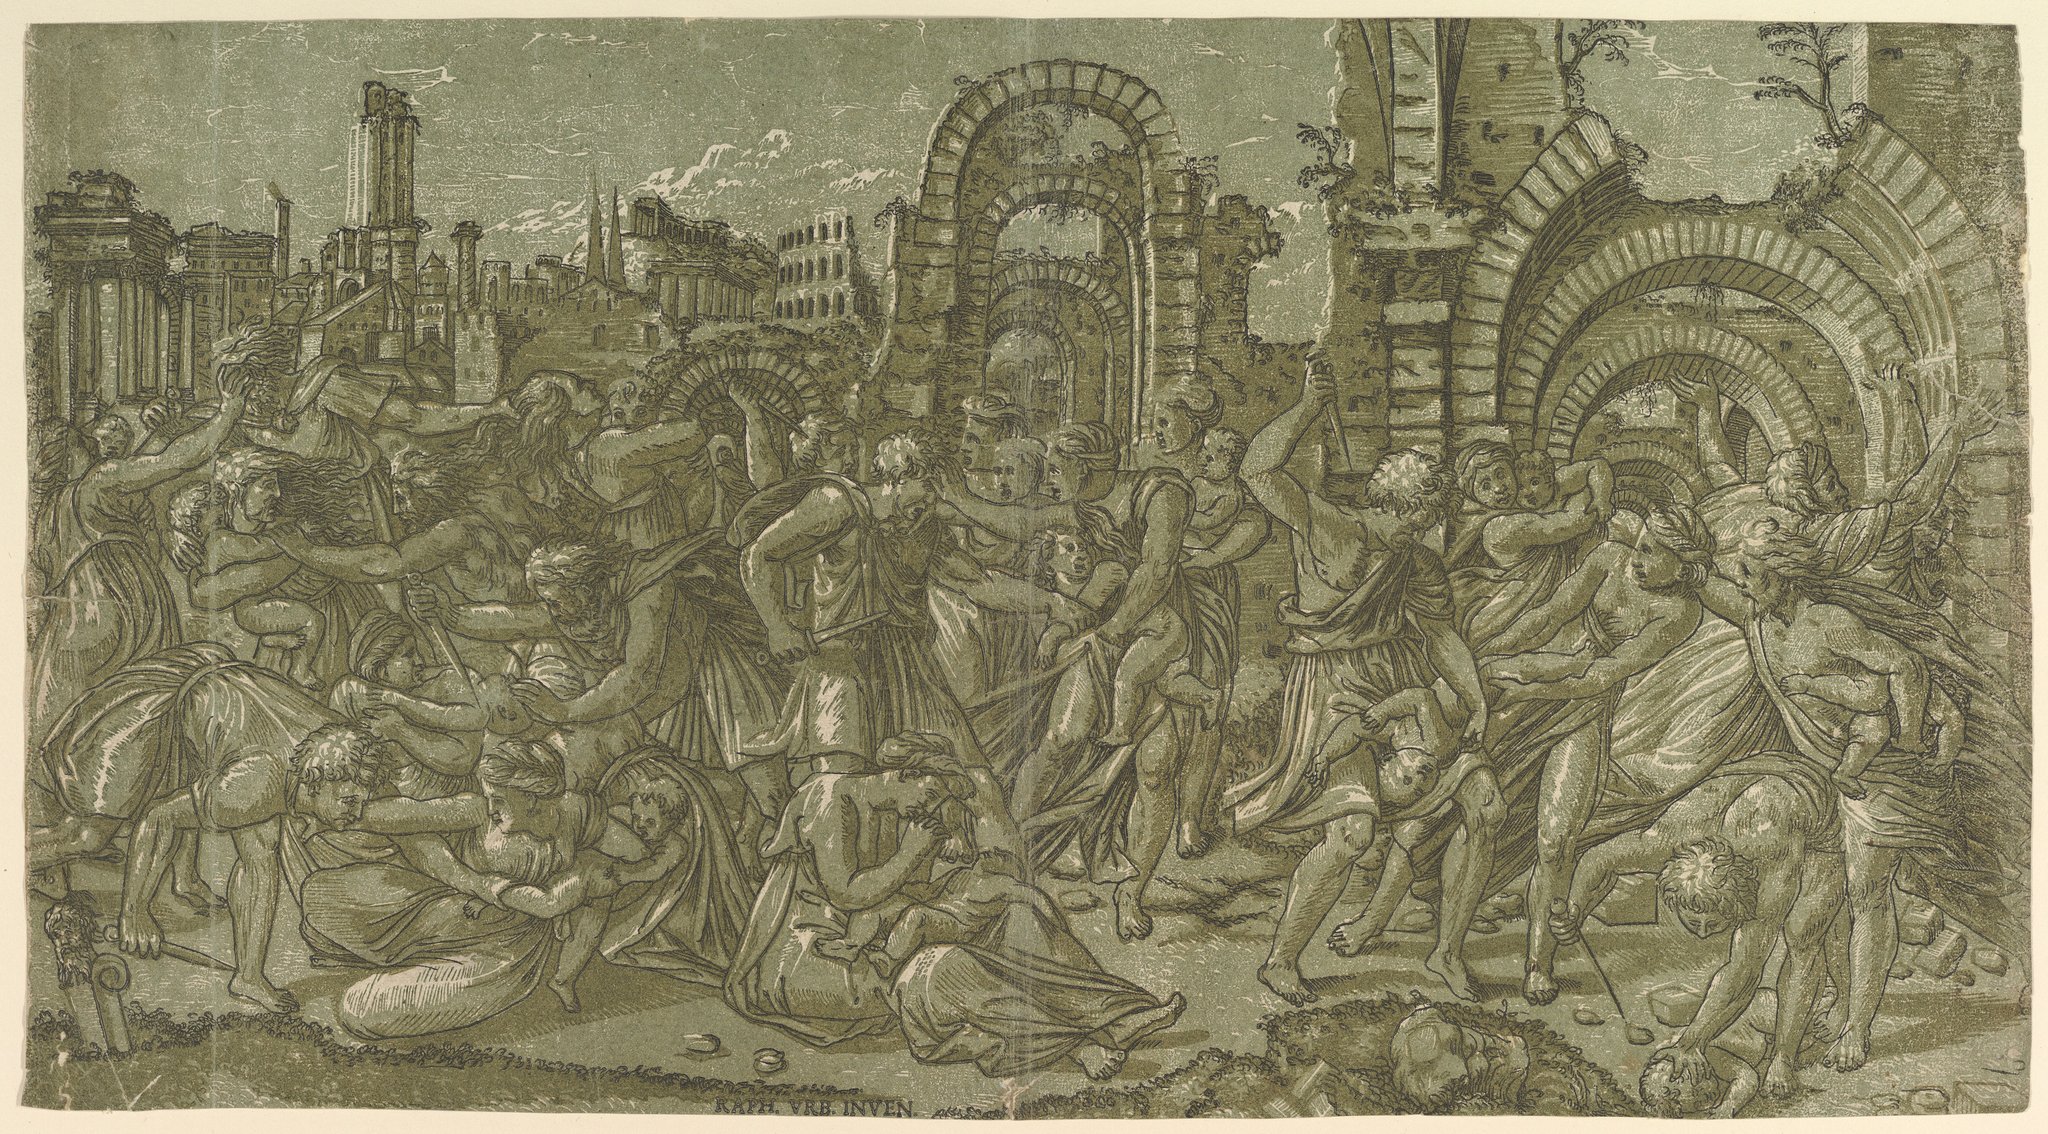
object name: print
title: Massacre of the Innocents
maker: master nd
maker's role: artist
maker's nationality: italian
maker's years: 1540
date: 1544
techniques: woodcut, printing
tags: massacres,boys,men,women